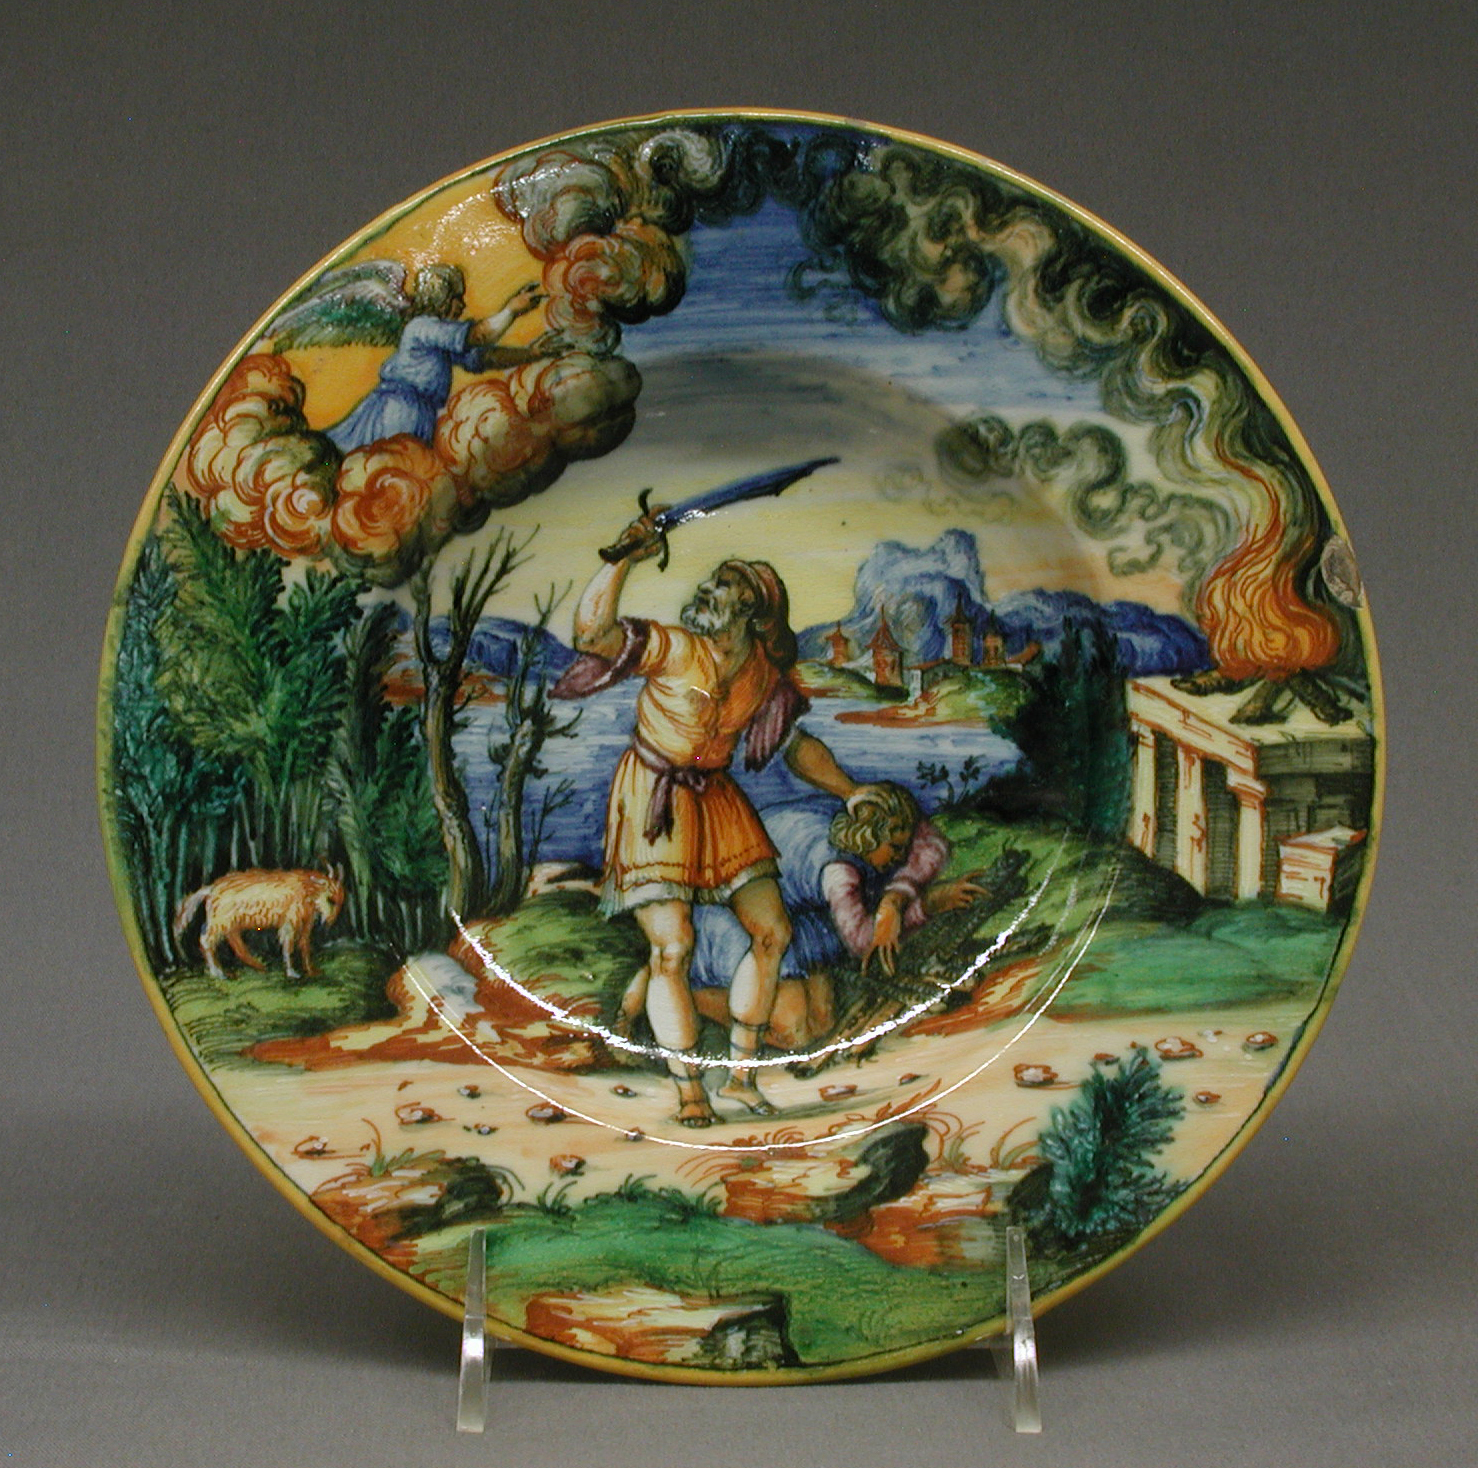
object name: dish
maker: fontana workshops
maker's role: maker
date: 1550-1560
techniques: maiolica, glazing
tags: swords,men,women,fire